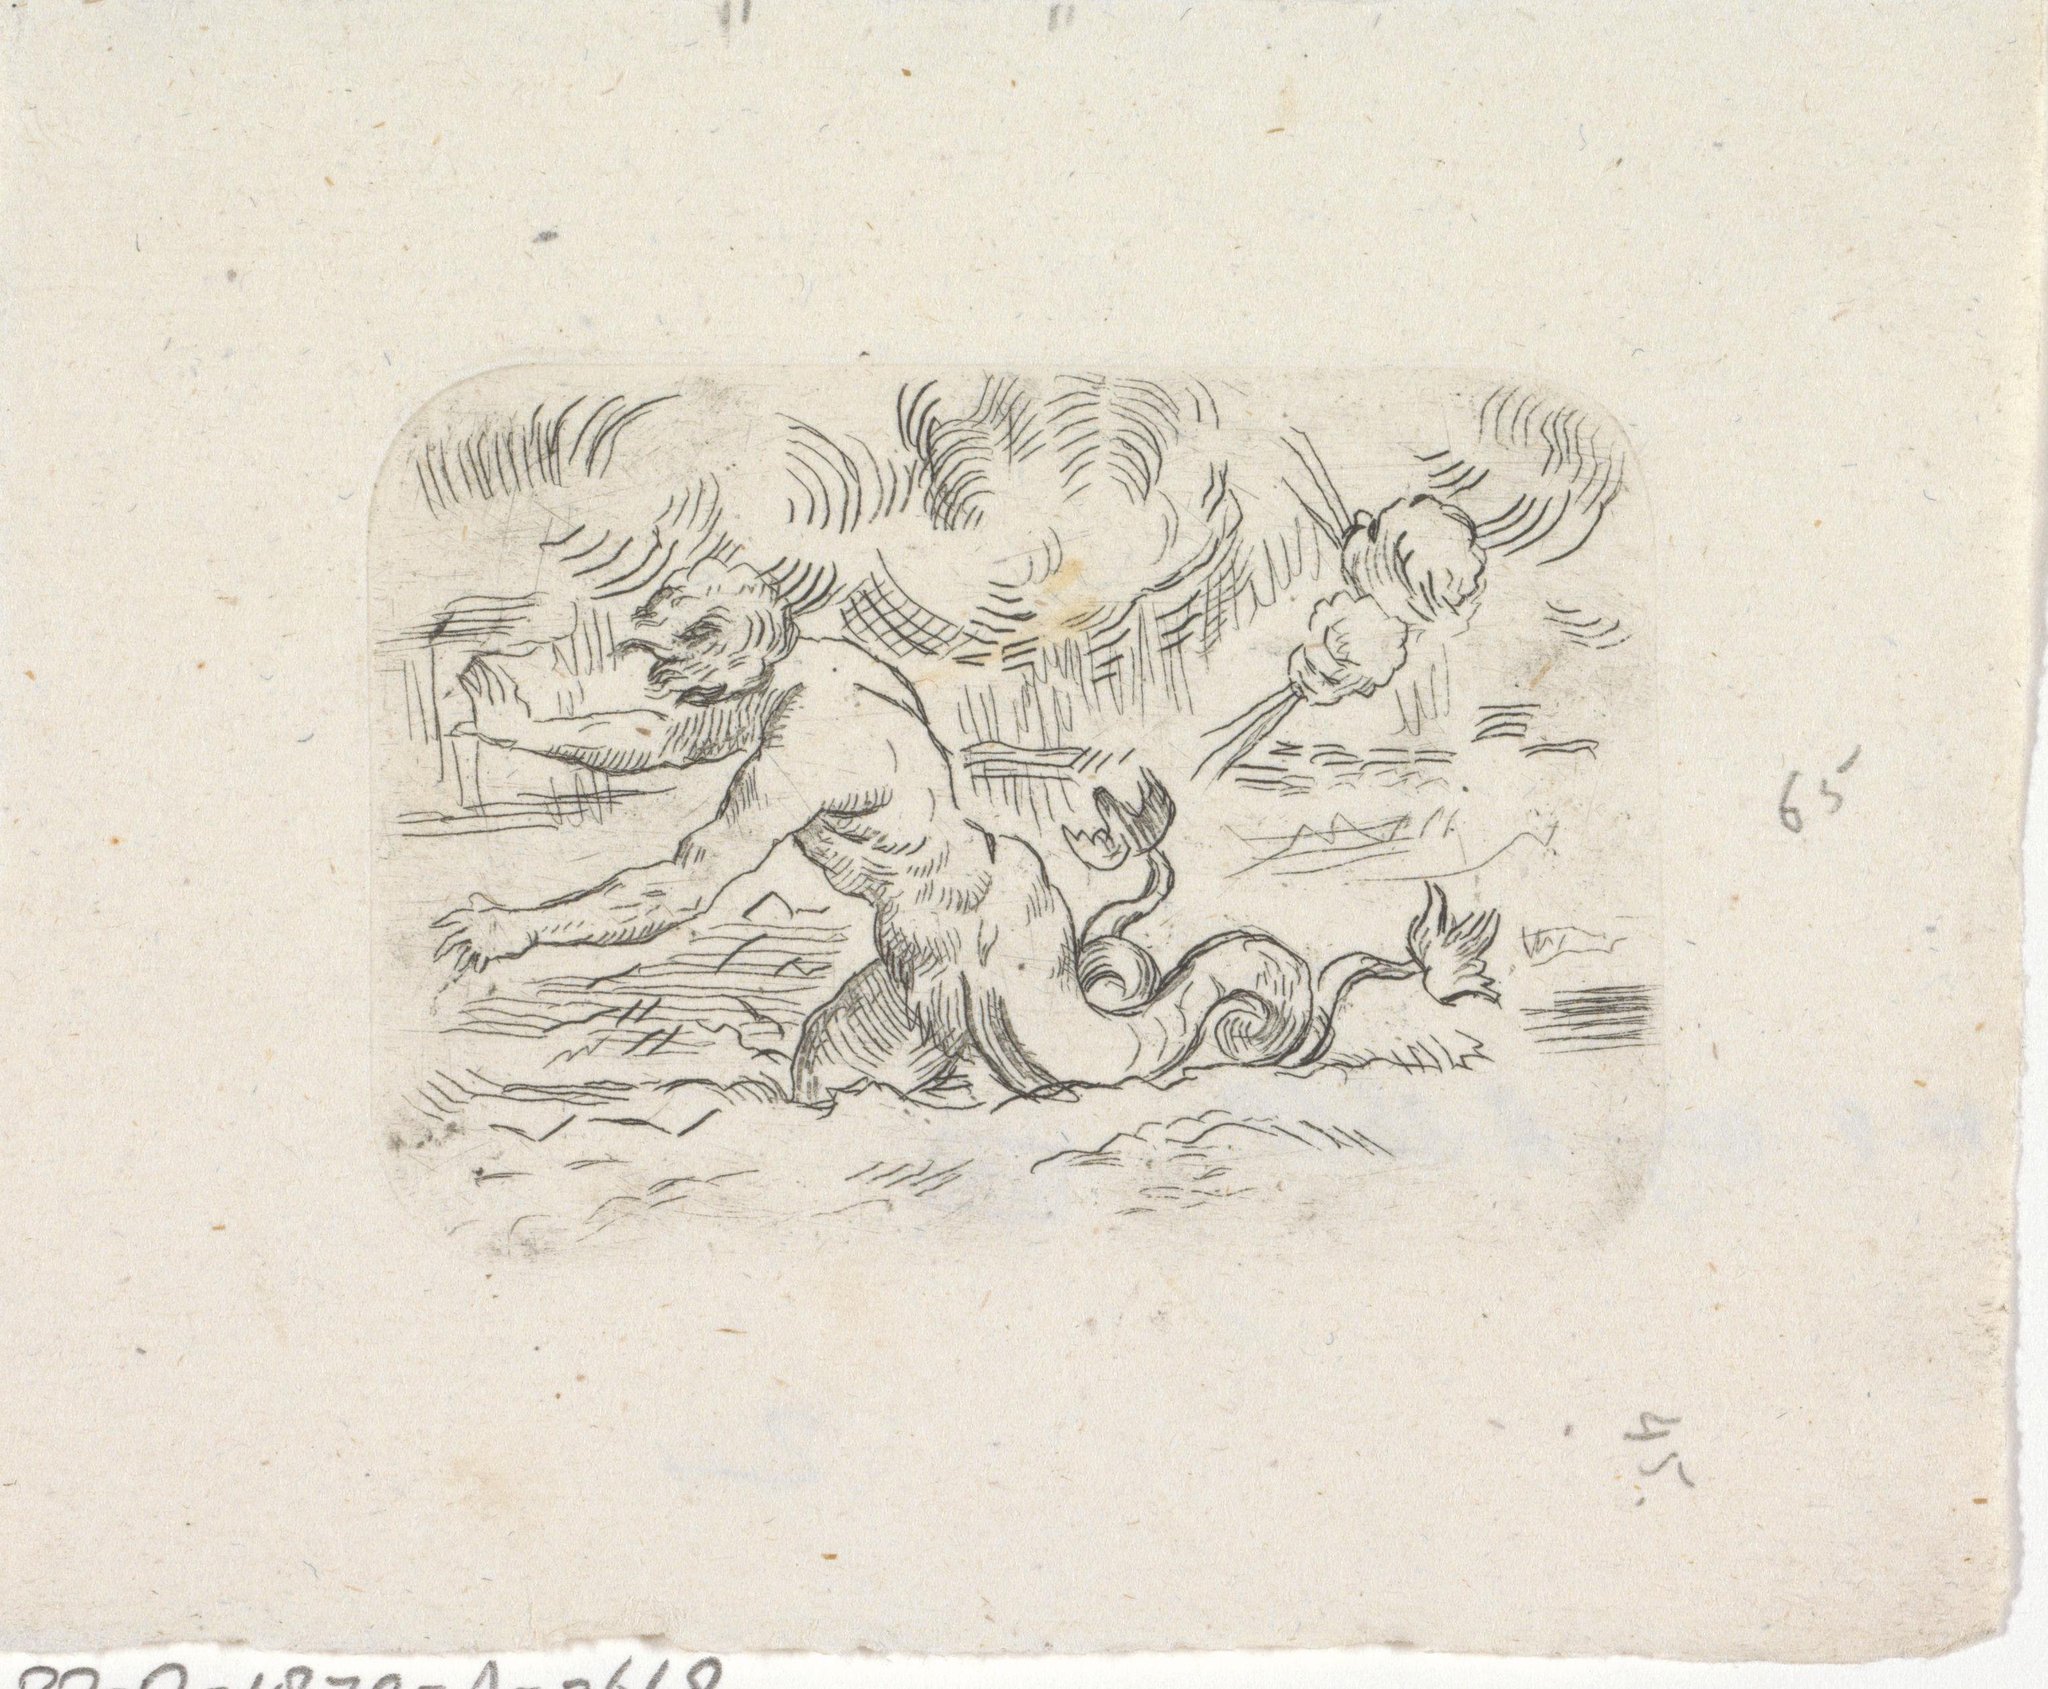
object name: print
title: Triton vluchtend voor de wind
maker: Anonymous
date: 1800-1879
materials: paper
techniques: etching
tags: triton(s)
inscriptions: collector's mark: Lugt 2227